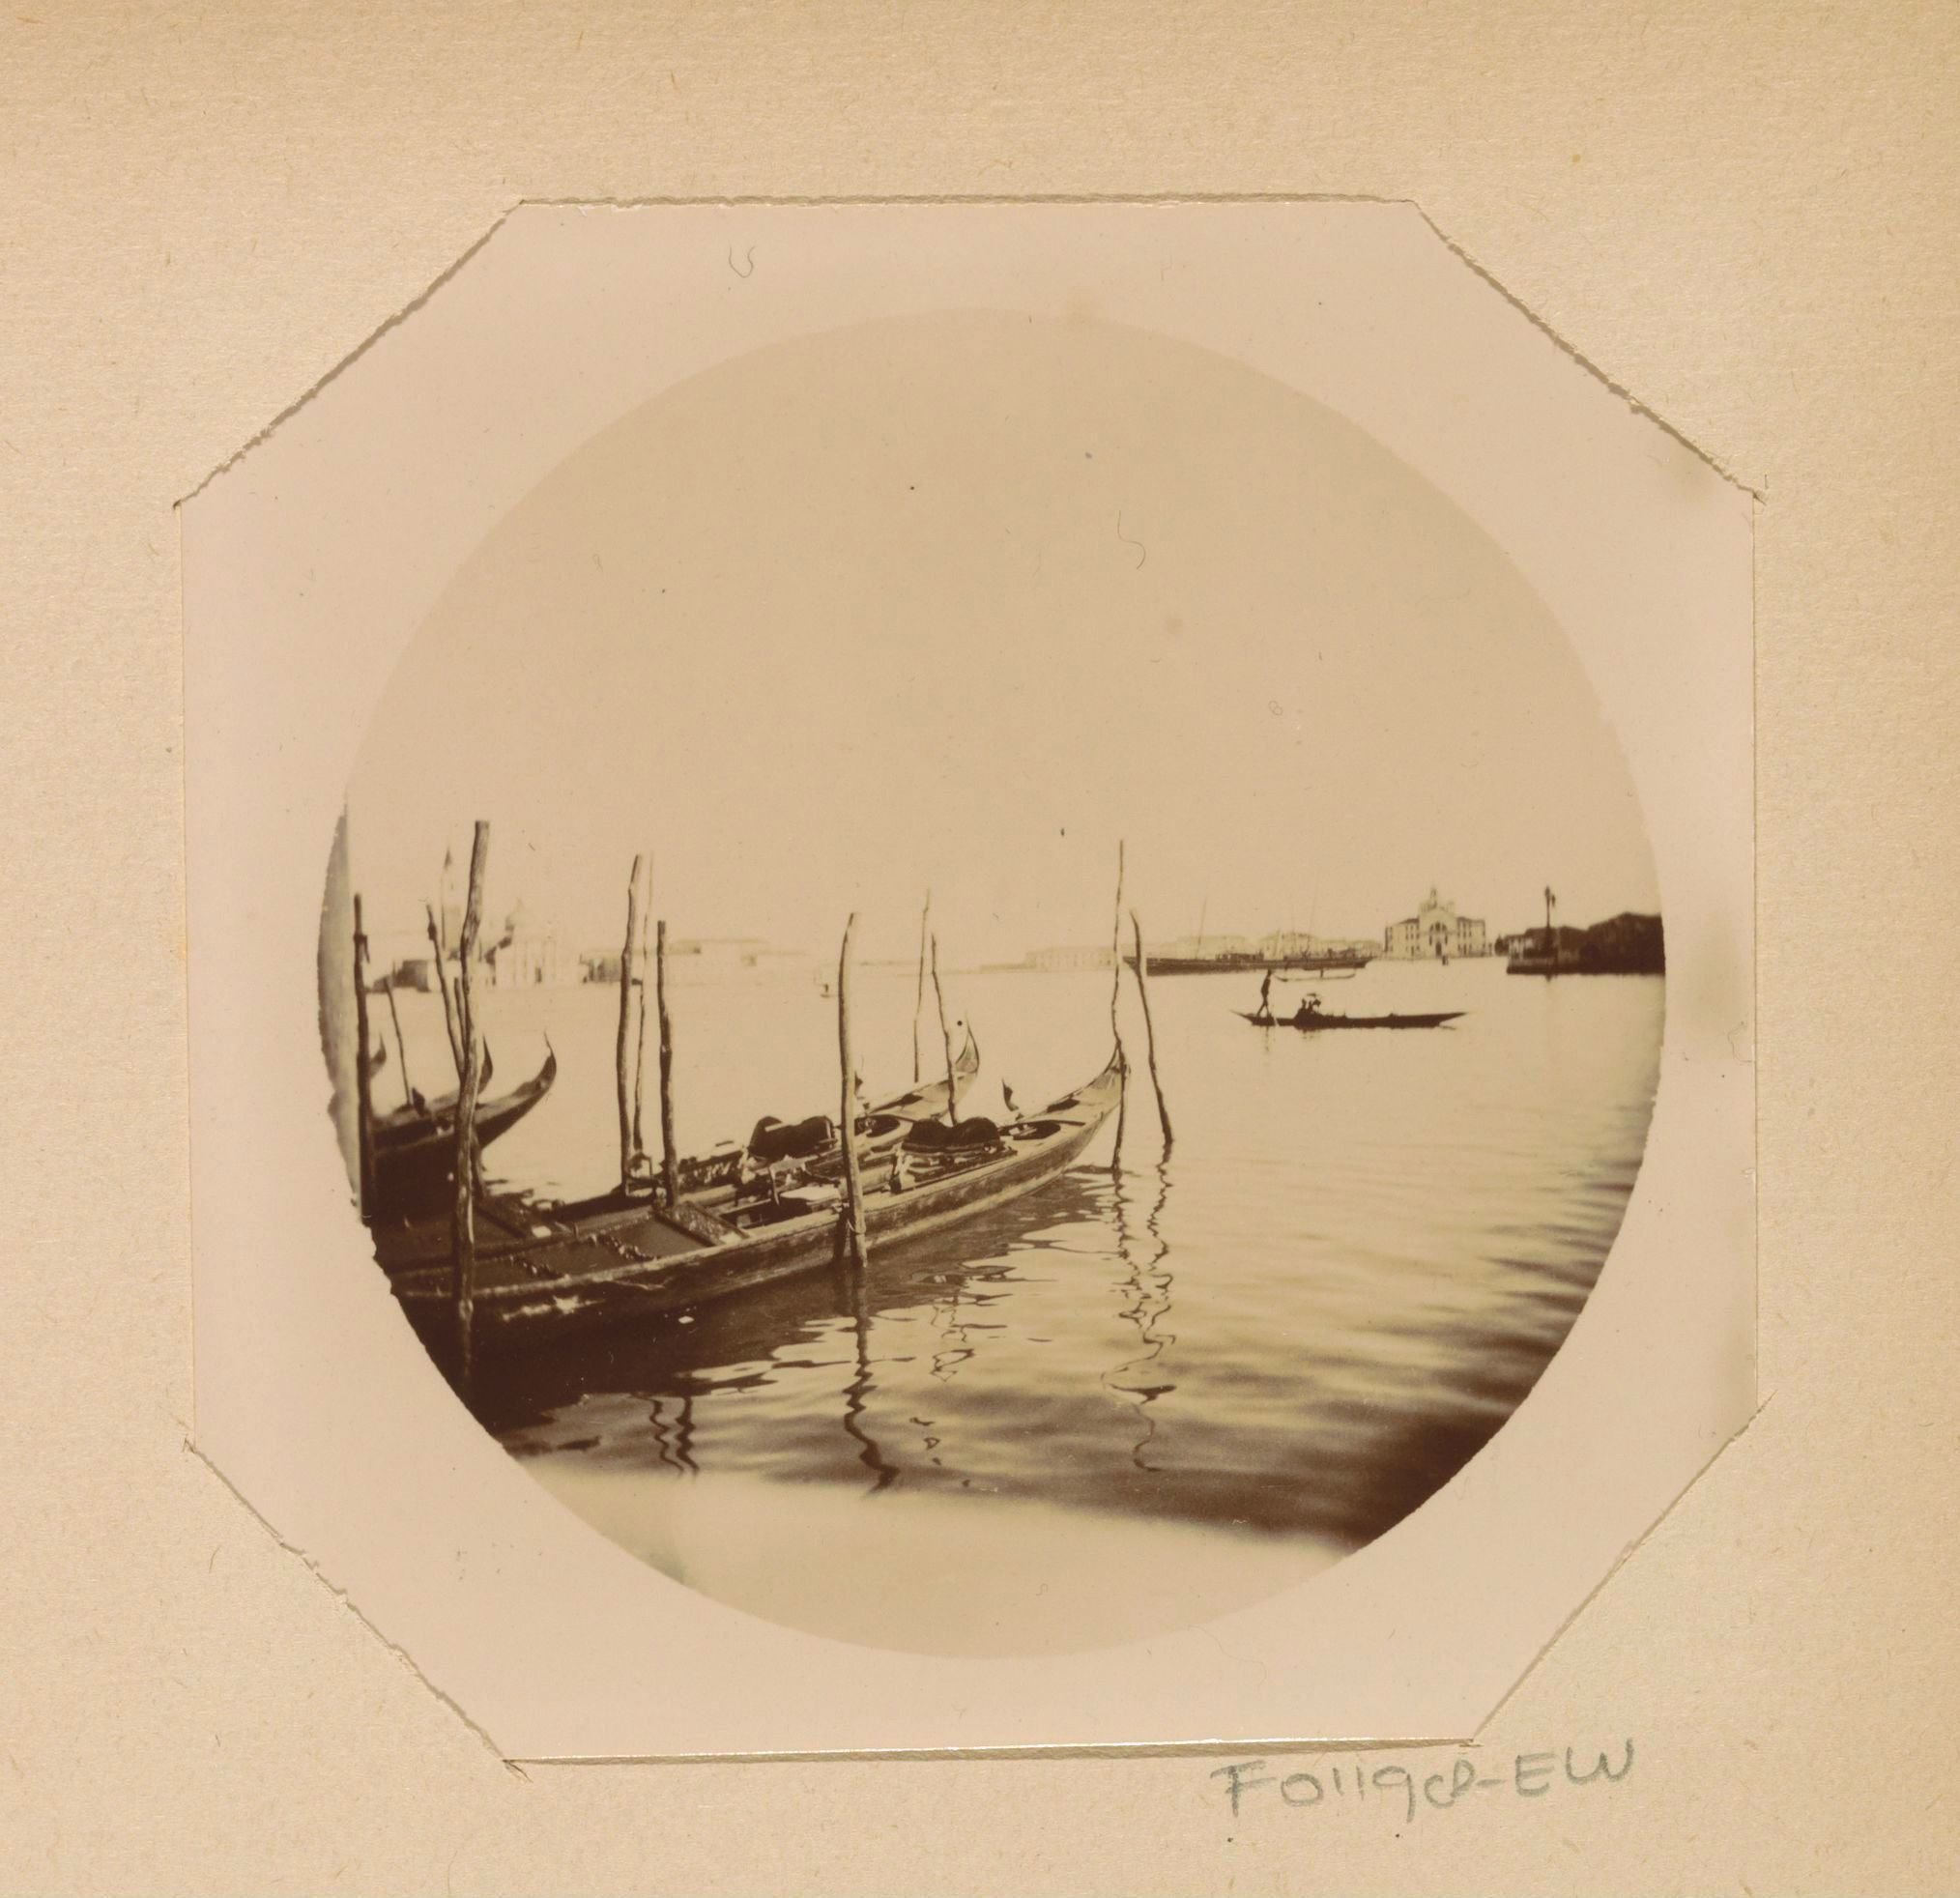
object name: photograph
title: Gezicht op gondels in de lagune van Venetië, in de verte rechts de Santa Maria della Presentazione en links de kerk van San Giorgio Maggiore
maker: johanna margaretha piek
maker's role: fotograaf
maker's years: 1870-1947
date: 1889-1893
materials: paper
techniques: gelatin silver print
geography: venice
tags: gondola